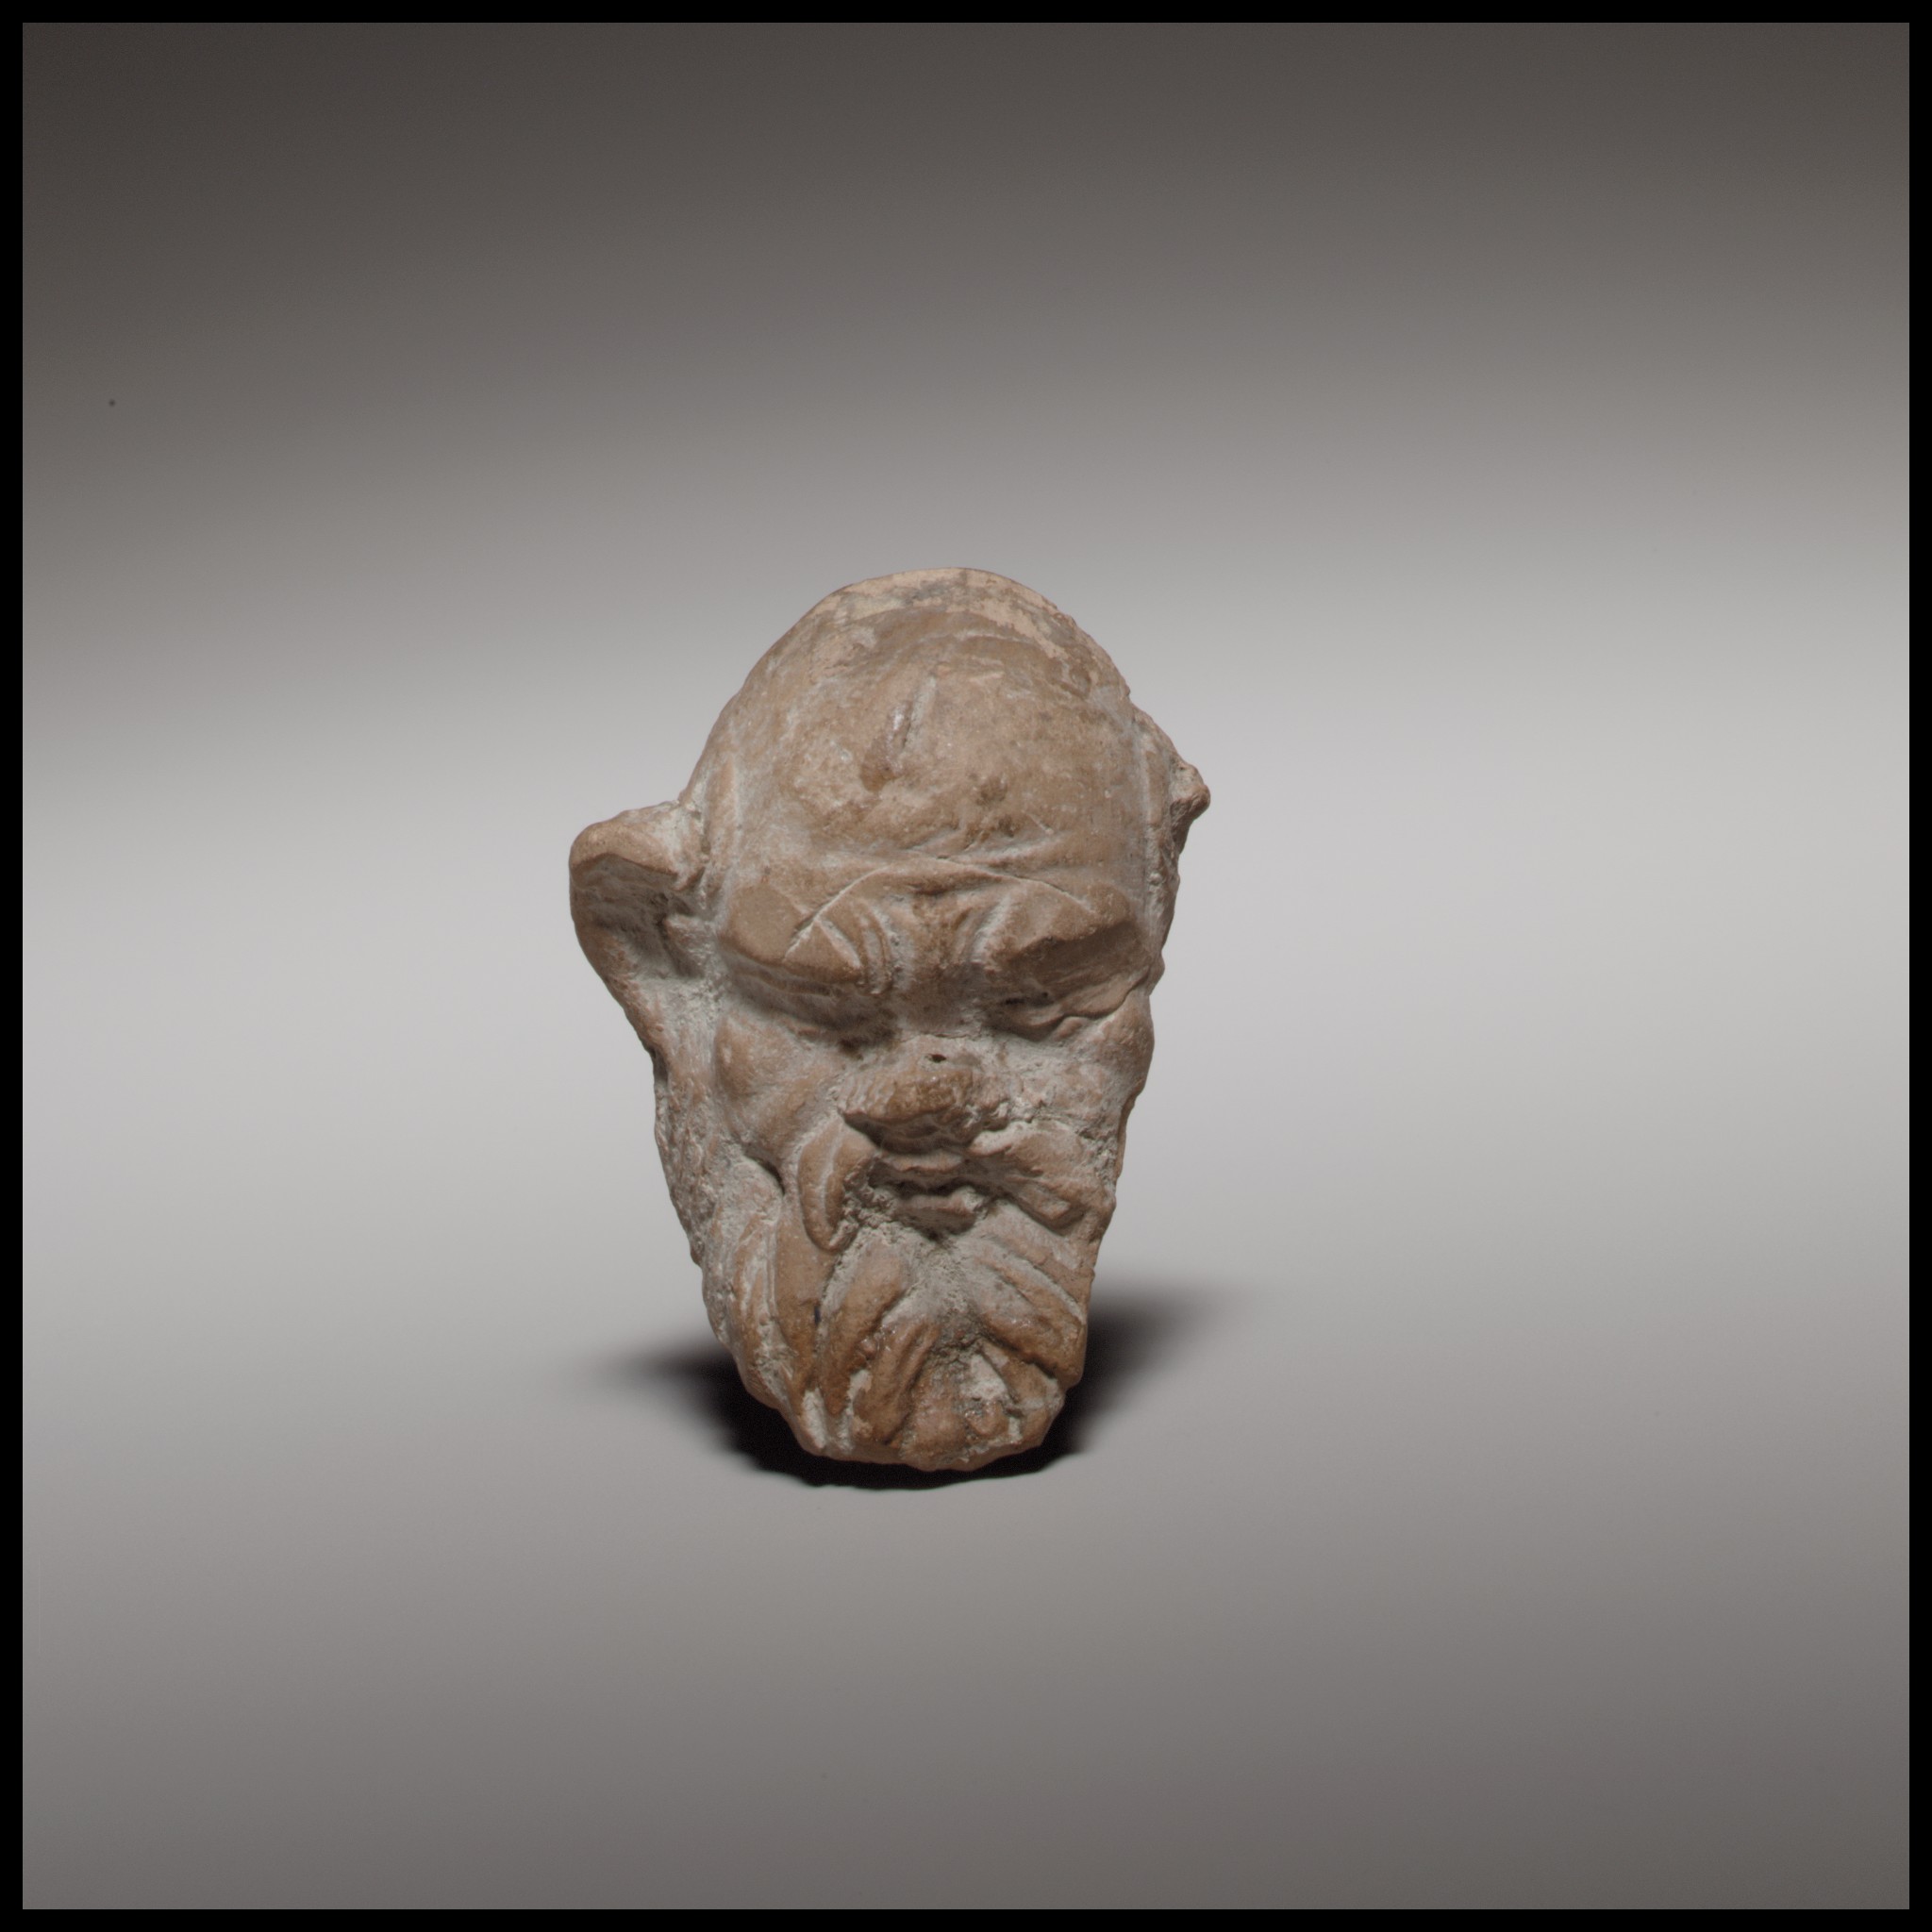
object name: head of silenos or mask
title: Head of Silenos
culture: cypriot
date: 200-101 BCE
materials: terracotta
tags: heads,silenus